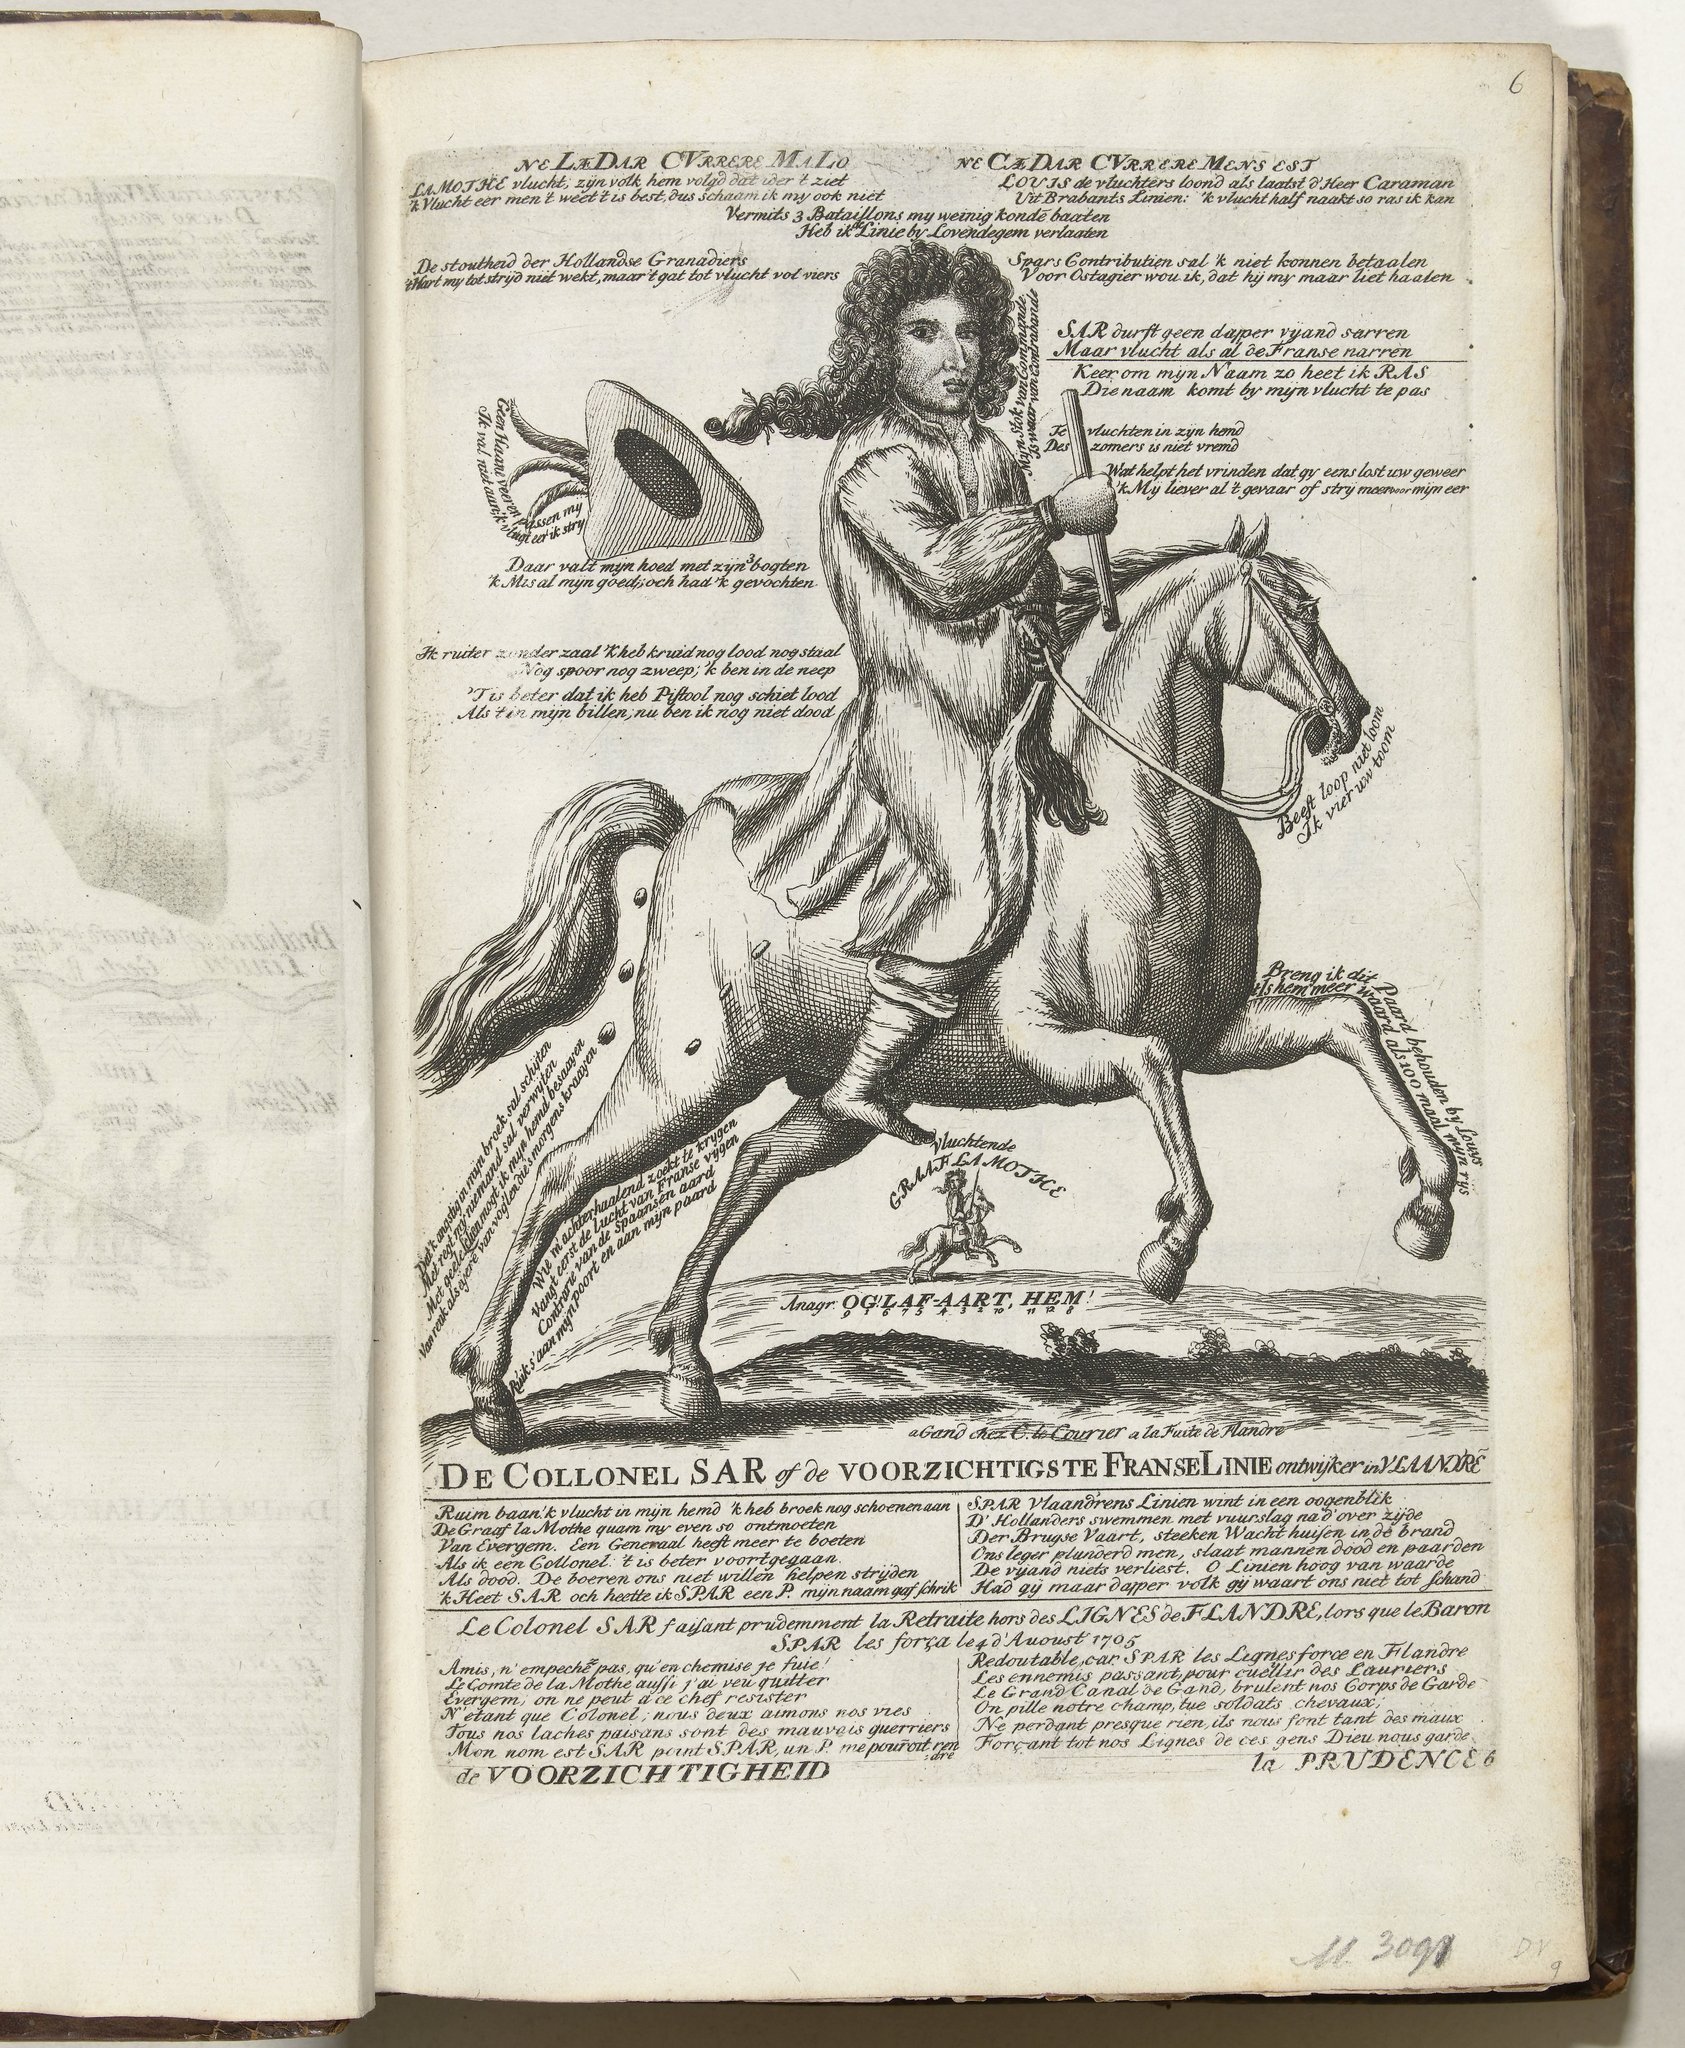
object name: cartoon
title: Spotprent op de vluchtende kolonel Sar, 1705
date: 1706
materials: paper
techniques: etching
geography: northern netherlands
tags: political caricatures and satires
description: Spotprent op de vluchtende kolonel Sar bij het doorbereken van de Vlaamse Linies op 4 augustus door de Staatse generaal Baron Sparre (of Spar). Met verzen in het Nederlands en Frans in de plaat. Prent nr. 6 (de Voorzichtigheid - la Prudence) in de serie van 7 prenten in de Koninklyke Almanach van 1705 in het prentwerk uitgegeven onder de verzameltitel 't Lust-Hof van Momus met de gebundelde series van spotprenten tijdens de jaren 1701-1713 van de Spaanse Successieoorlog.